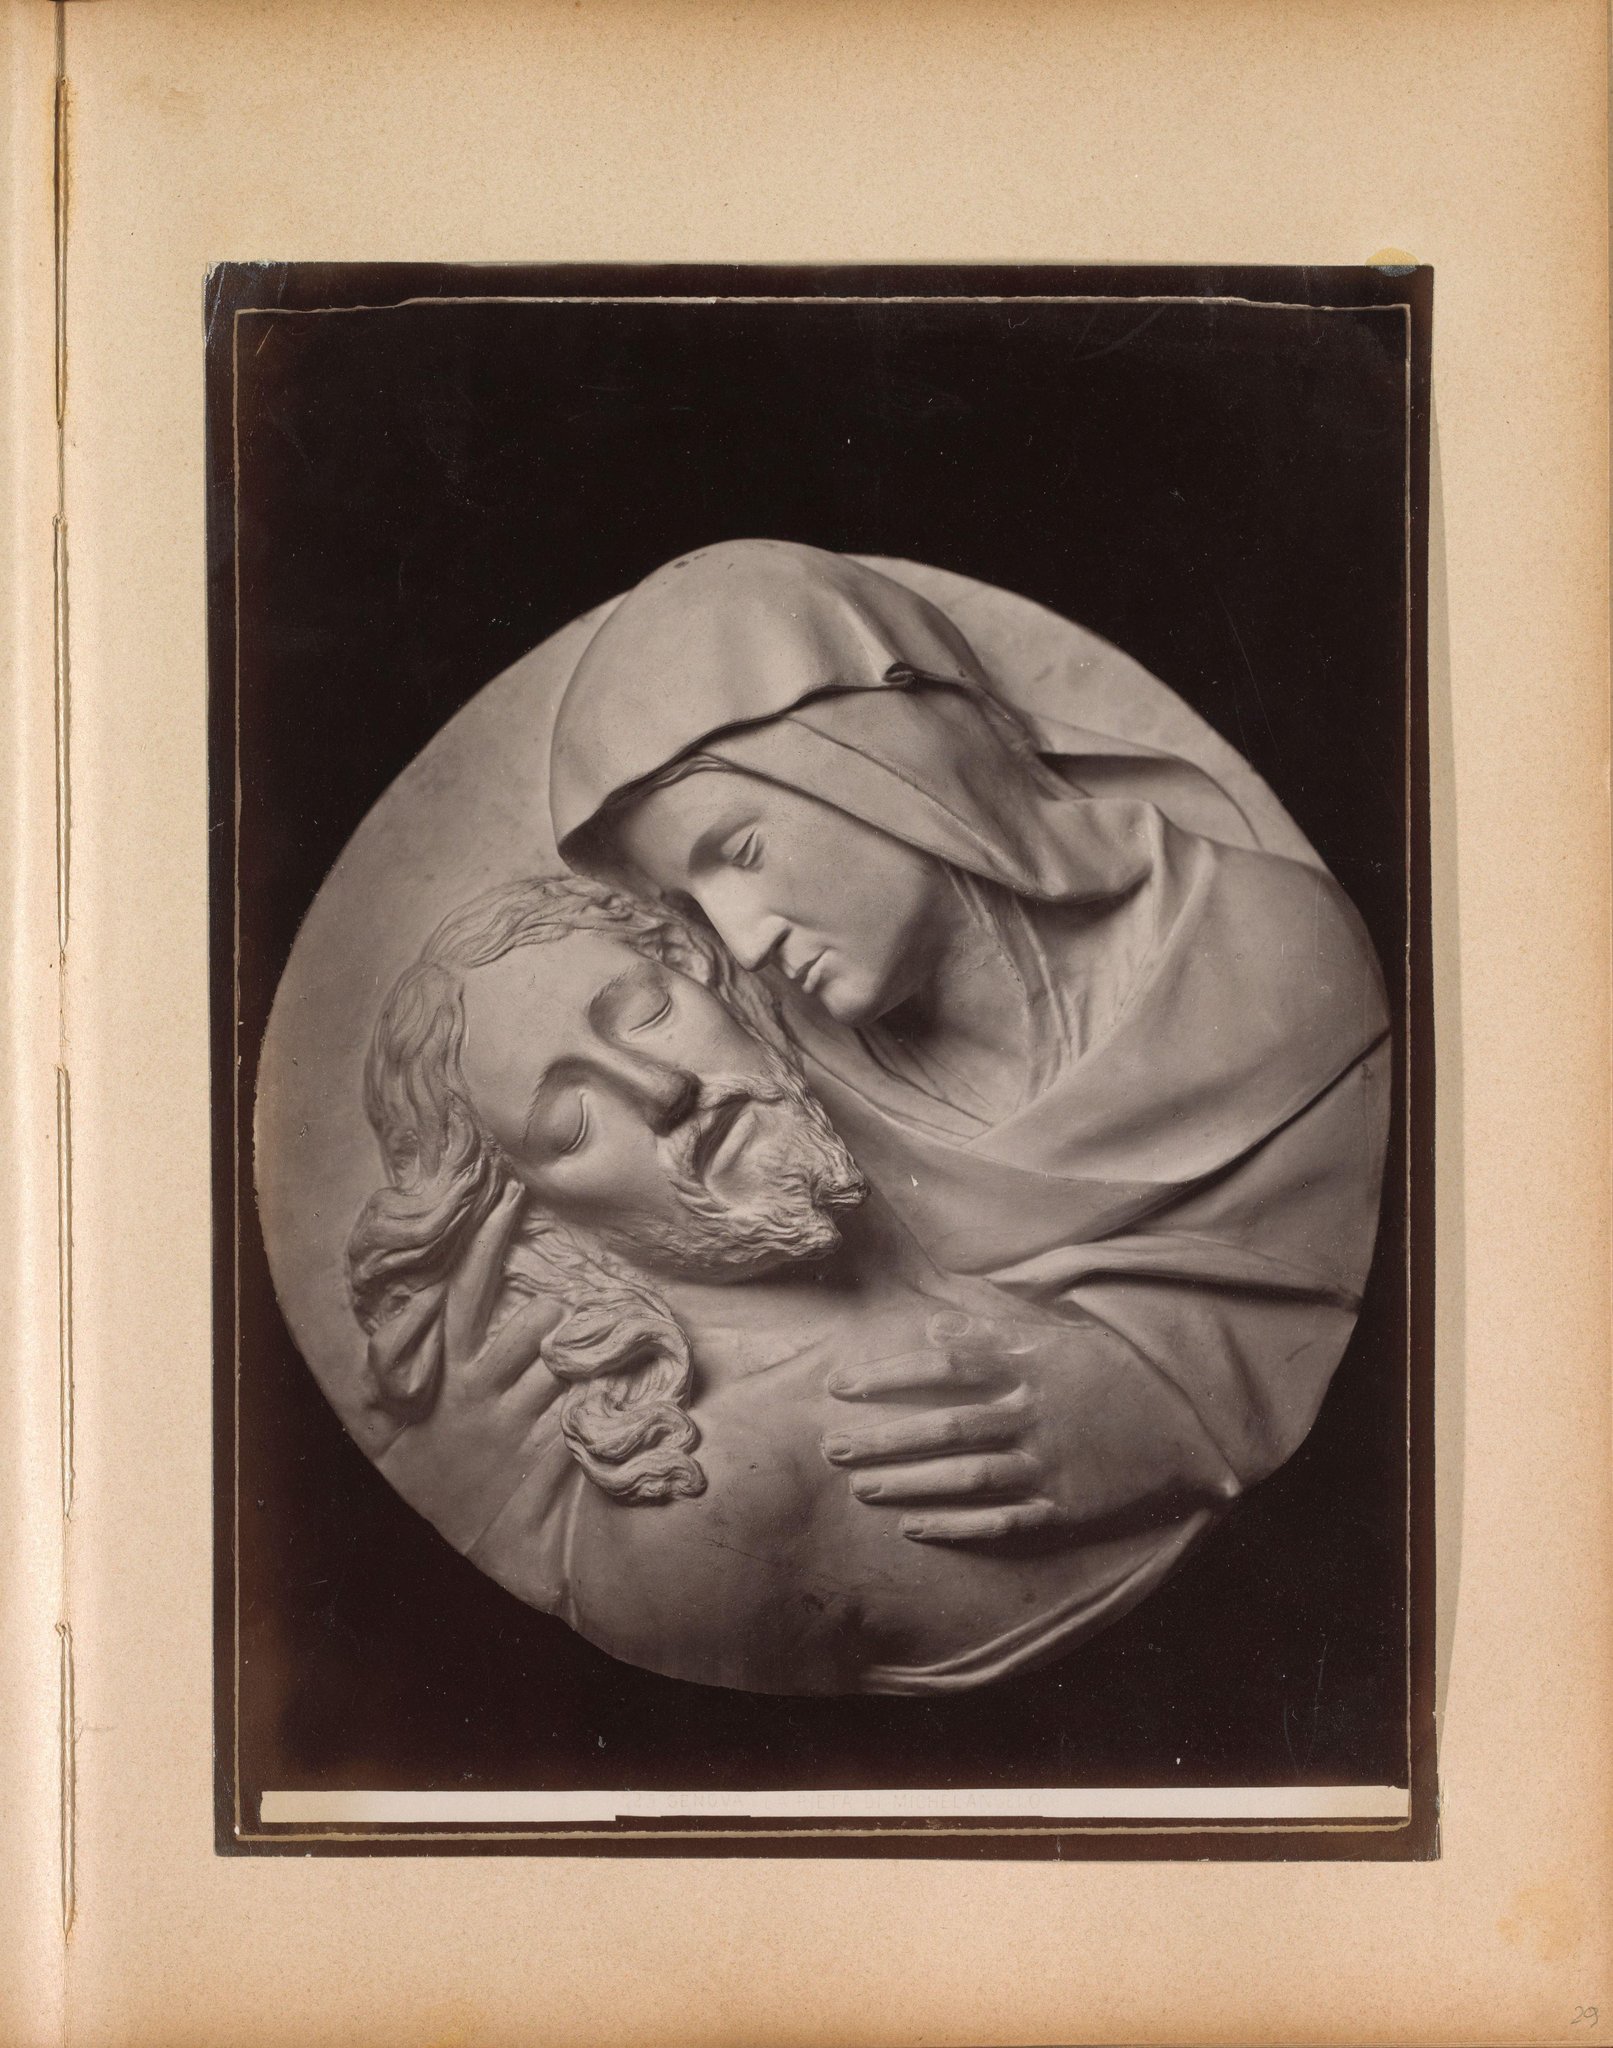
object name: album leaf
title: Piëta, reliëf vermoedelijk in Genua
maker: alfredo noack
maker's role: fotograaf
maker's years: 1833-1895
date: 1870-1900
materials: paper, photographic support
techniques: albumen print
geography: genoa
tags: the mourning over the dead christ (+ mary), sculpture (+ relief ~ sculpture)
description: Onderdeel van Reisalbum met foto's van bezienswaardigheden in Italië en Zuid-Frankrijk.